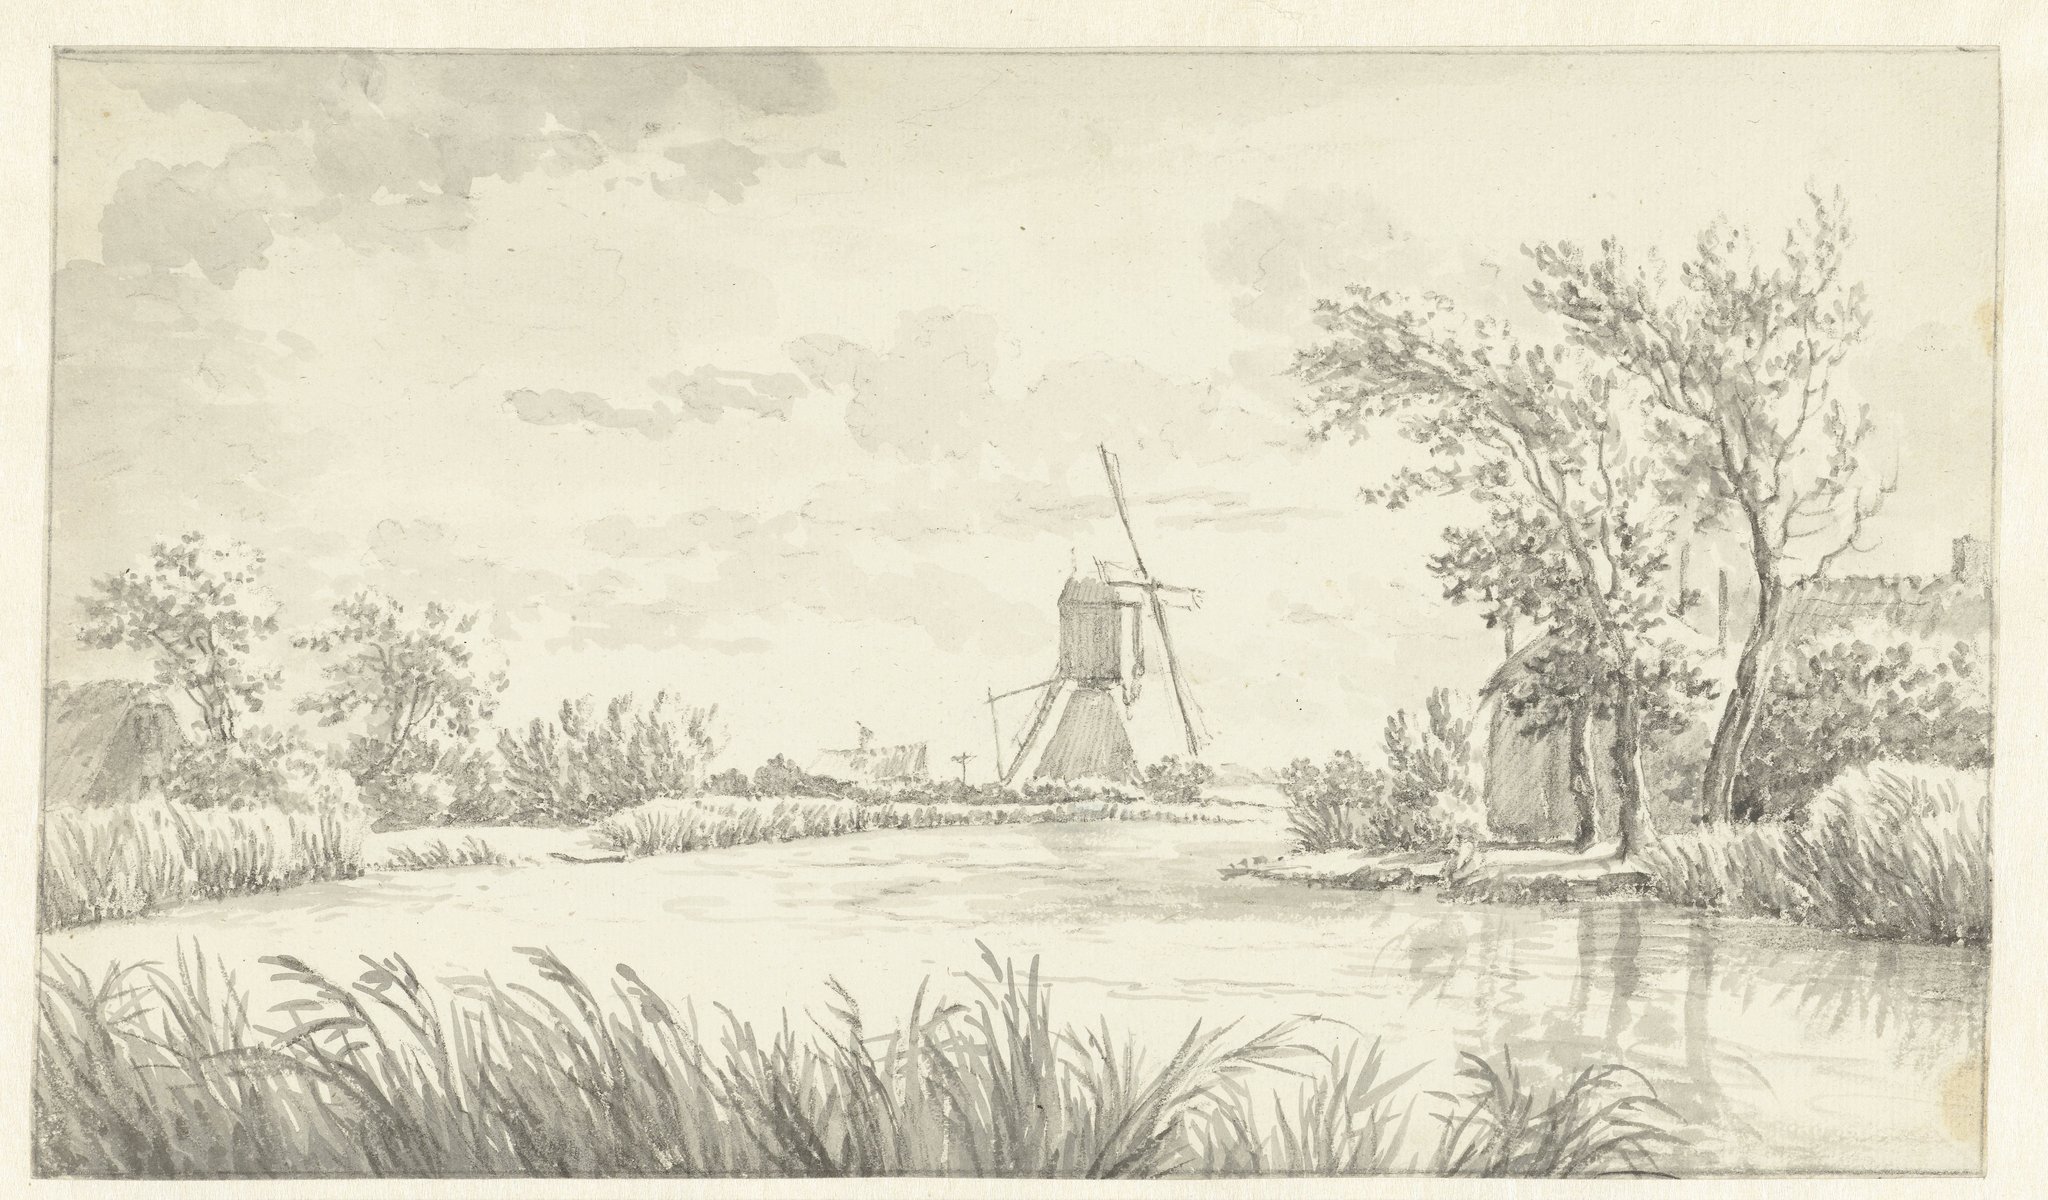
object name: drawing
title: De Kromme Mijdrecht met een wipmolen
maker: egbert van drielst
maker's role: draughtsman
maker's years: 1745-1818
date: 1755-1818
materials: chalk, paper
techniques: brush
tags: windmill in landscape